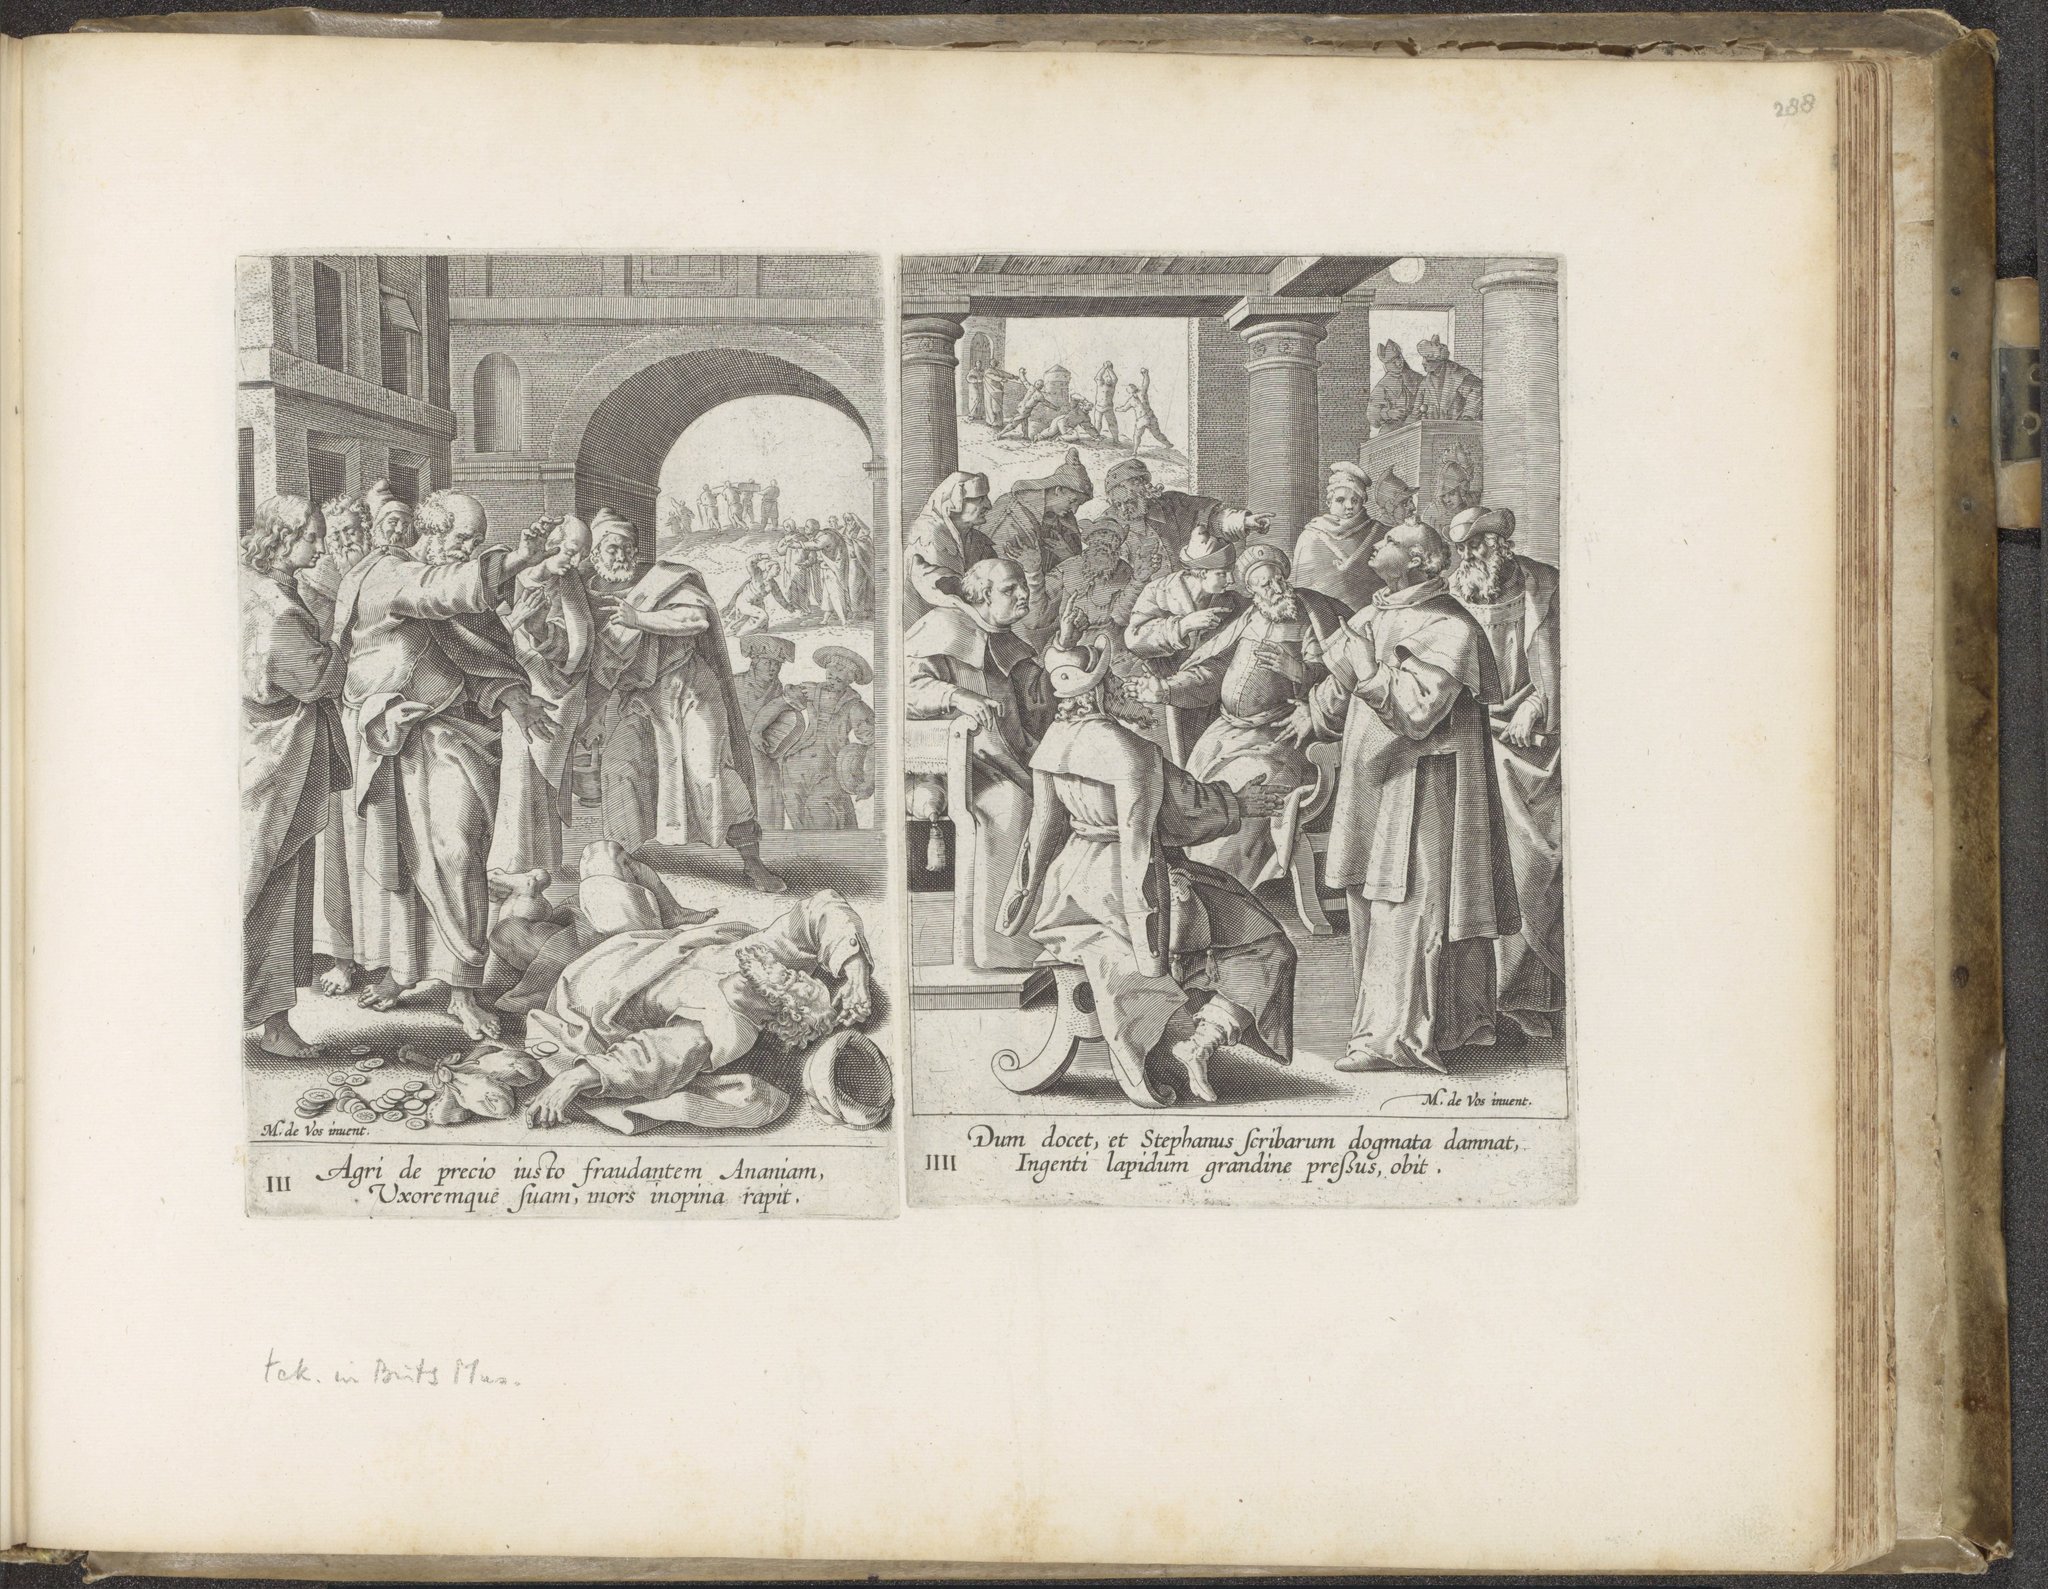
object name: print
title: Handelingen van de apostelen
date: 1591-1600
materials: paper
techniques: engraving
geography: amsterdam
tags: the stoning of stephen; the witnesses lay down their clothes at saul's feet, stephen preaching (and baptizing), ananias, rebuked by peter, falls down and dies between his gifts, peter questioning sapphira, who then dies too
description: Twee voorstellingen op een albumblad. Links de dood van Ananias en Saffira. Vooraan ligt het lichaam van Ananias op de grond naast zijn geldbuidel. Voor hem staat Petrus, die Ananias met woorden geselde, omdat hij een deel van de opbrengst uit de verkoop van zijn bezit ten behoeve van de armen had achtergehouden, waarna Ananias stierf. Omstanders, onder wie enkele apostelen, kijken toe. Op de achtergrond ondergaat Saffira, Ananias' vrouw, hetzelfde lot. In de verte worden de lichamen weggedragen. Op de rechter voorstelling preekt Stefanus. Hij draagt een dalmatiek en wordt omringd door verontwaardigde toehoorders. In de verte wordt hij gestenigd. Onder beide voorstellingen een tweeregelig onderschrift in het Latijn. De prenten maken deel uit van een album.